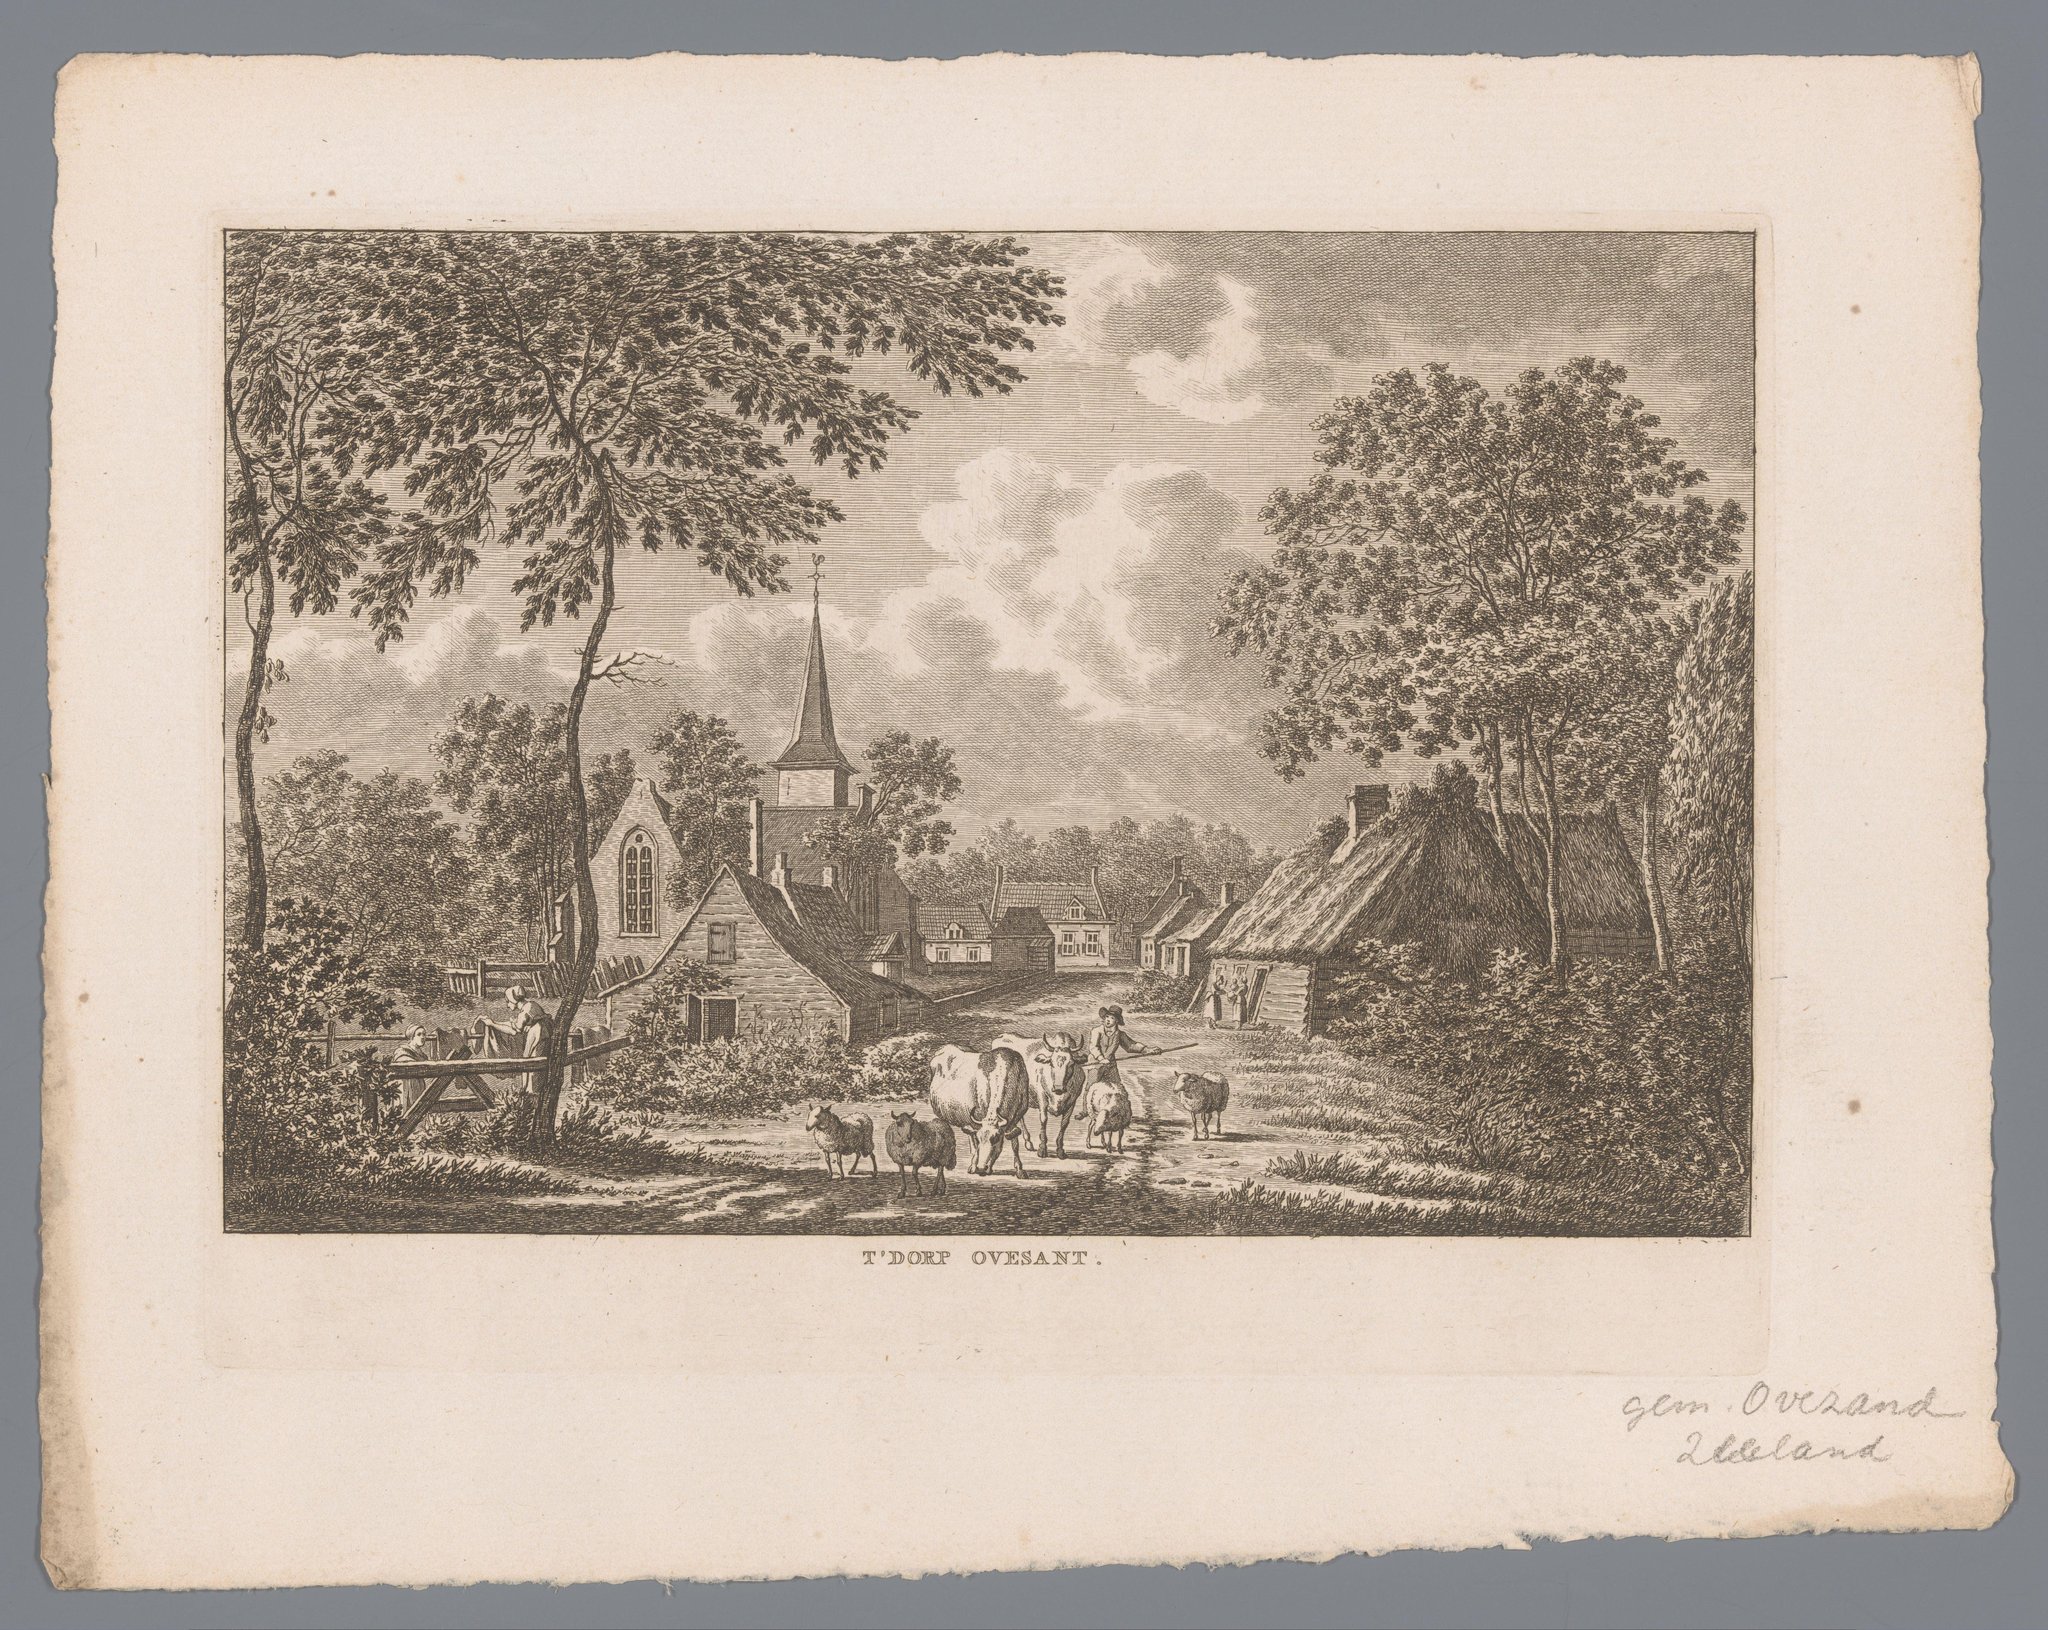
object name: print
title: T'Dorp Ovesant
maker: carel frederik bendorp (i)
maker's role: print maker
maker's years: 1736-1814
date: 1786-1792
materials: paper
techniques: etching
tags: cattle, village (+ city(-scape) with figures, staffage)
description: Prent uit: Vaderlandsche gezichten, of afbeeldingen van den tegenwoordigen staat der Vereenigde Nederlanden (…). Amsterdam: Hendrik Gartman, Willem Vermandel en Jan Willem Smit, 1786-1792. Uitgegeven in afleveringen met ieder een eigen bifolium en inhoudsopgave. Alle prenten in deze publicatie zijn gegraveerd door Carel Frederik Bendorp (I) en, in de meeste gevallen, gebaseerd op tekeningen van Jan Bulthuis.